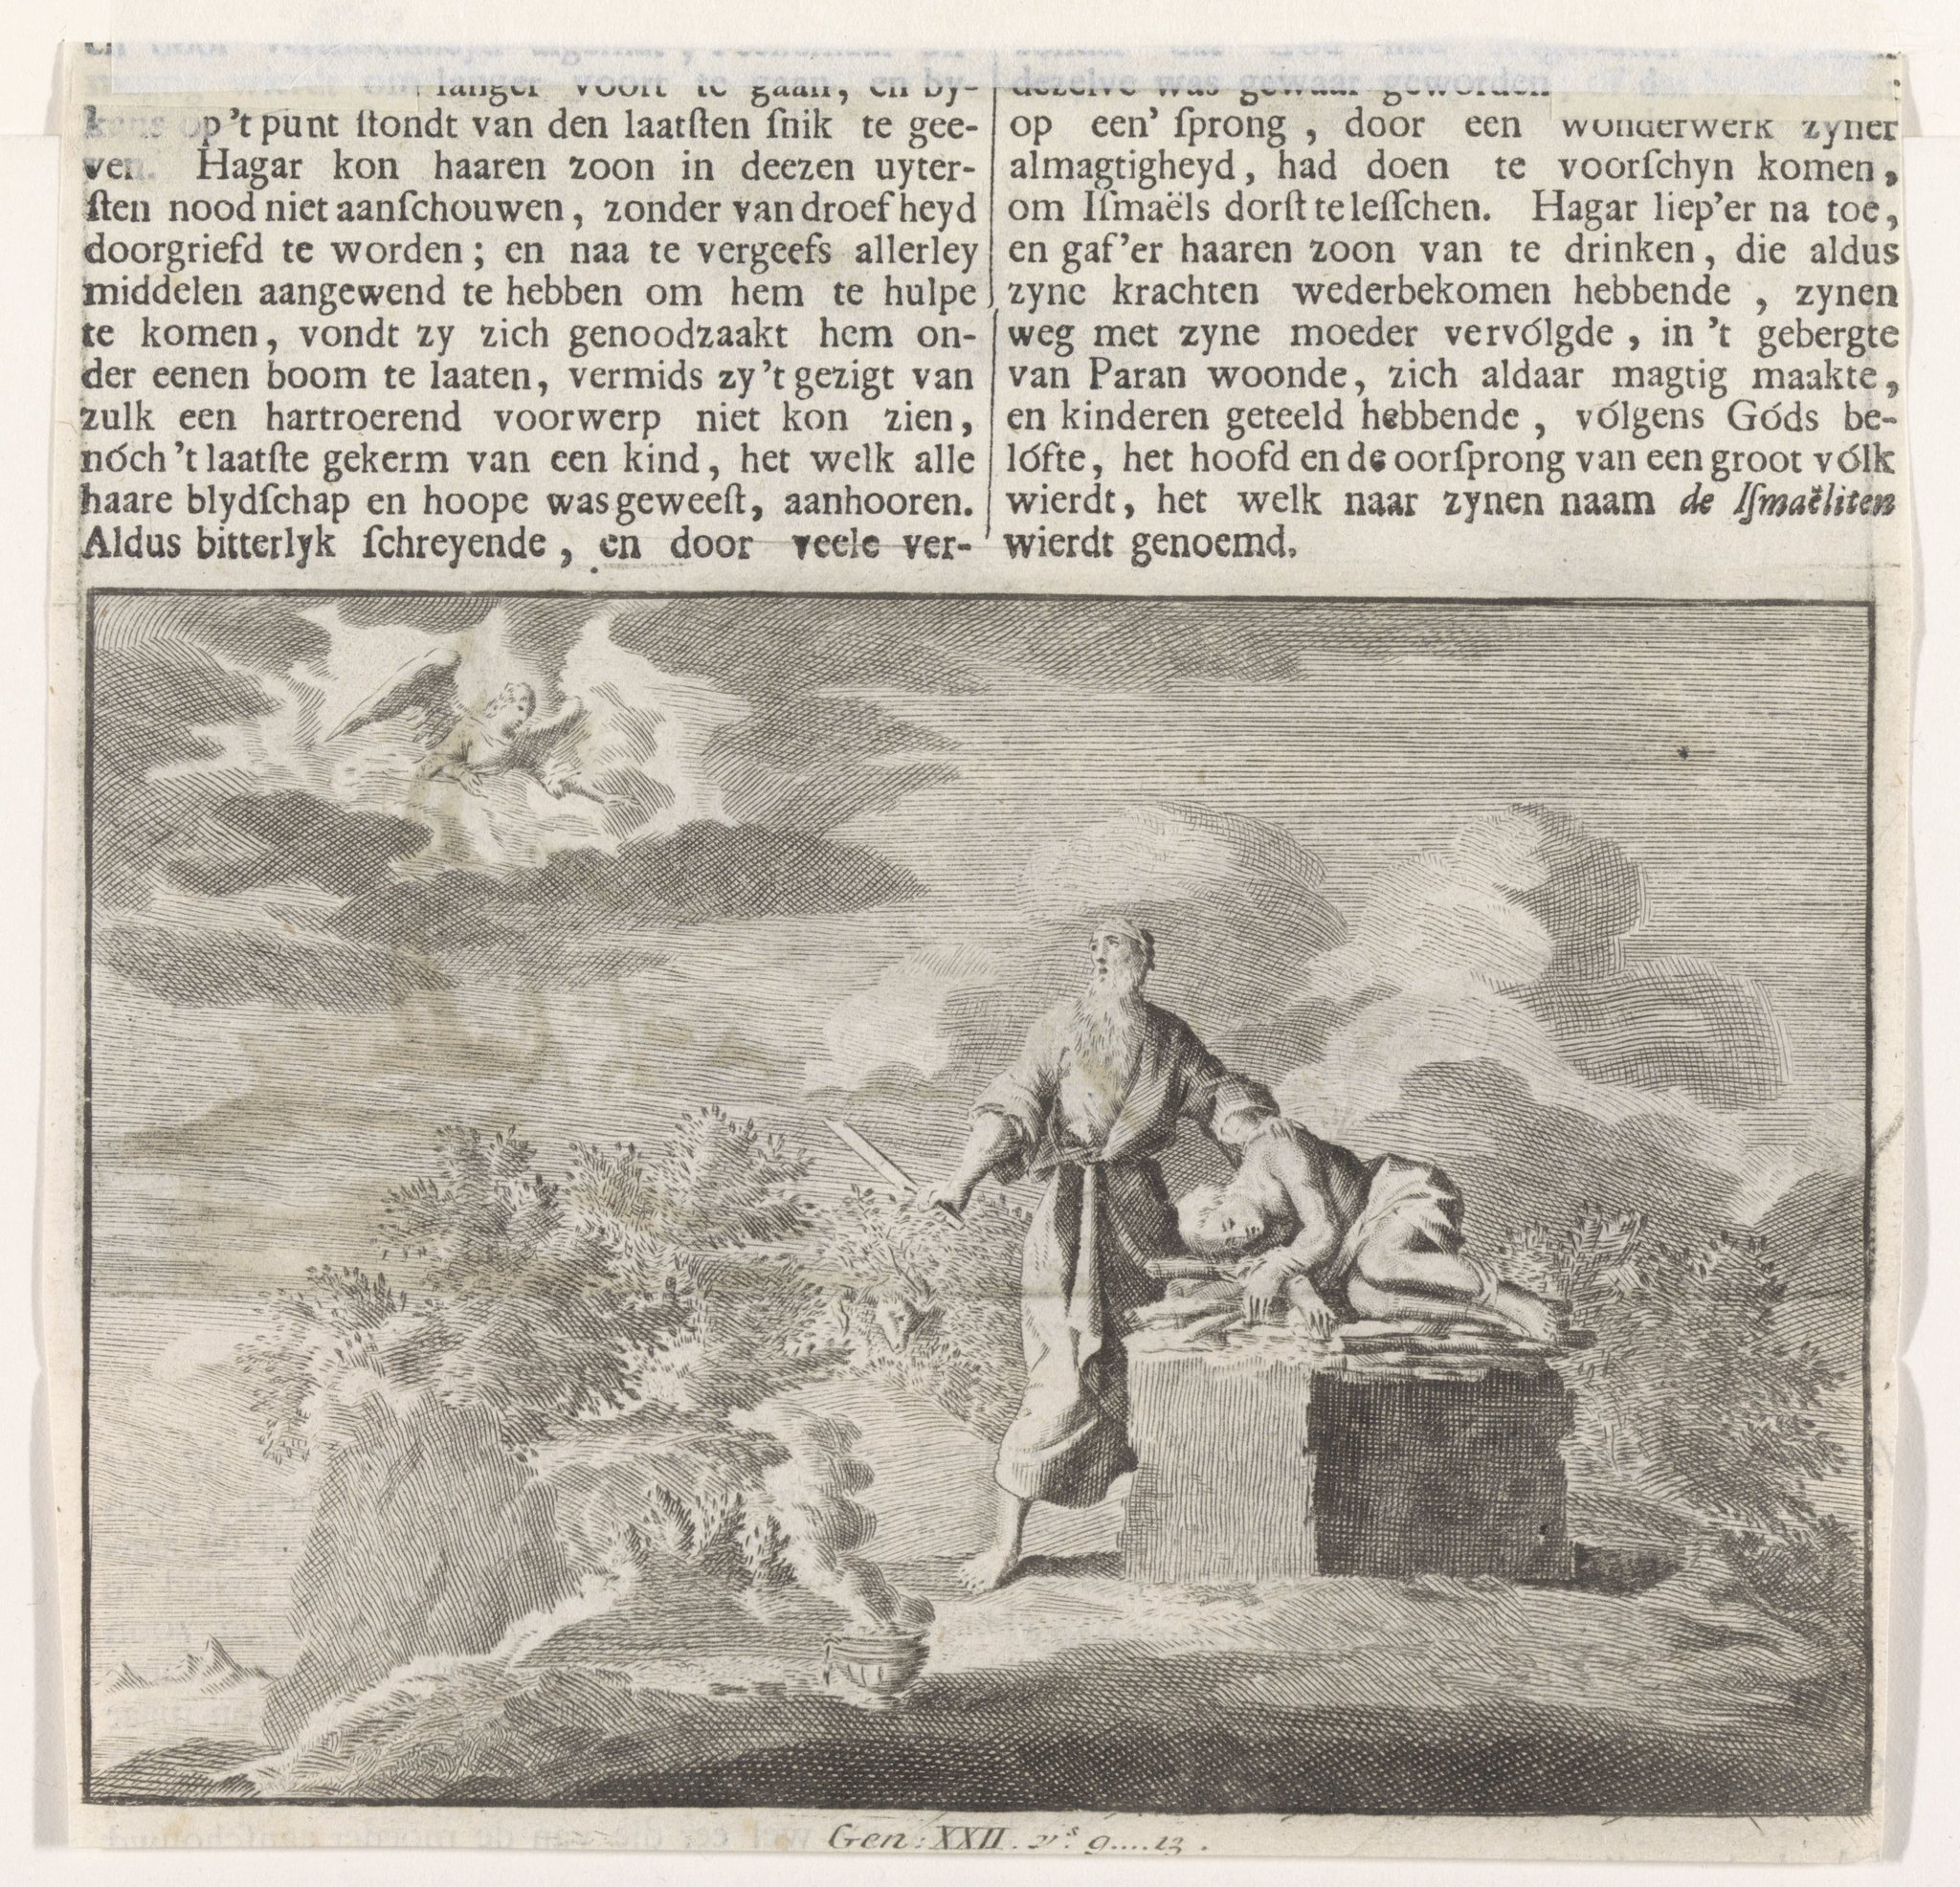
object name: print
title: Offer van Isaak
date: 1703-1762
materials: paper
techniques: etching, letterpress printing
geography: haarlem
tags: when abraham has his hand raised to kill isaac, god or the hand of god restrains abraham's hand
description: De prent komt een eerste keer voor als boekillustratie voor David Martin. Historie des Ouden en Nieuwen Testaments. Amsterdam, Pieter Mortier, 1703. Deel I. De boekillustraties voor de Mortierbijbel hebben verschillende staten en kopieën, waarbij de chronologische volgorde moeilijk te achterhalen valt. Als boekillustraties werden ze bovendien herhaaldelijk opnieuw gebruikt voor andere boekwerken.